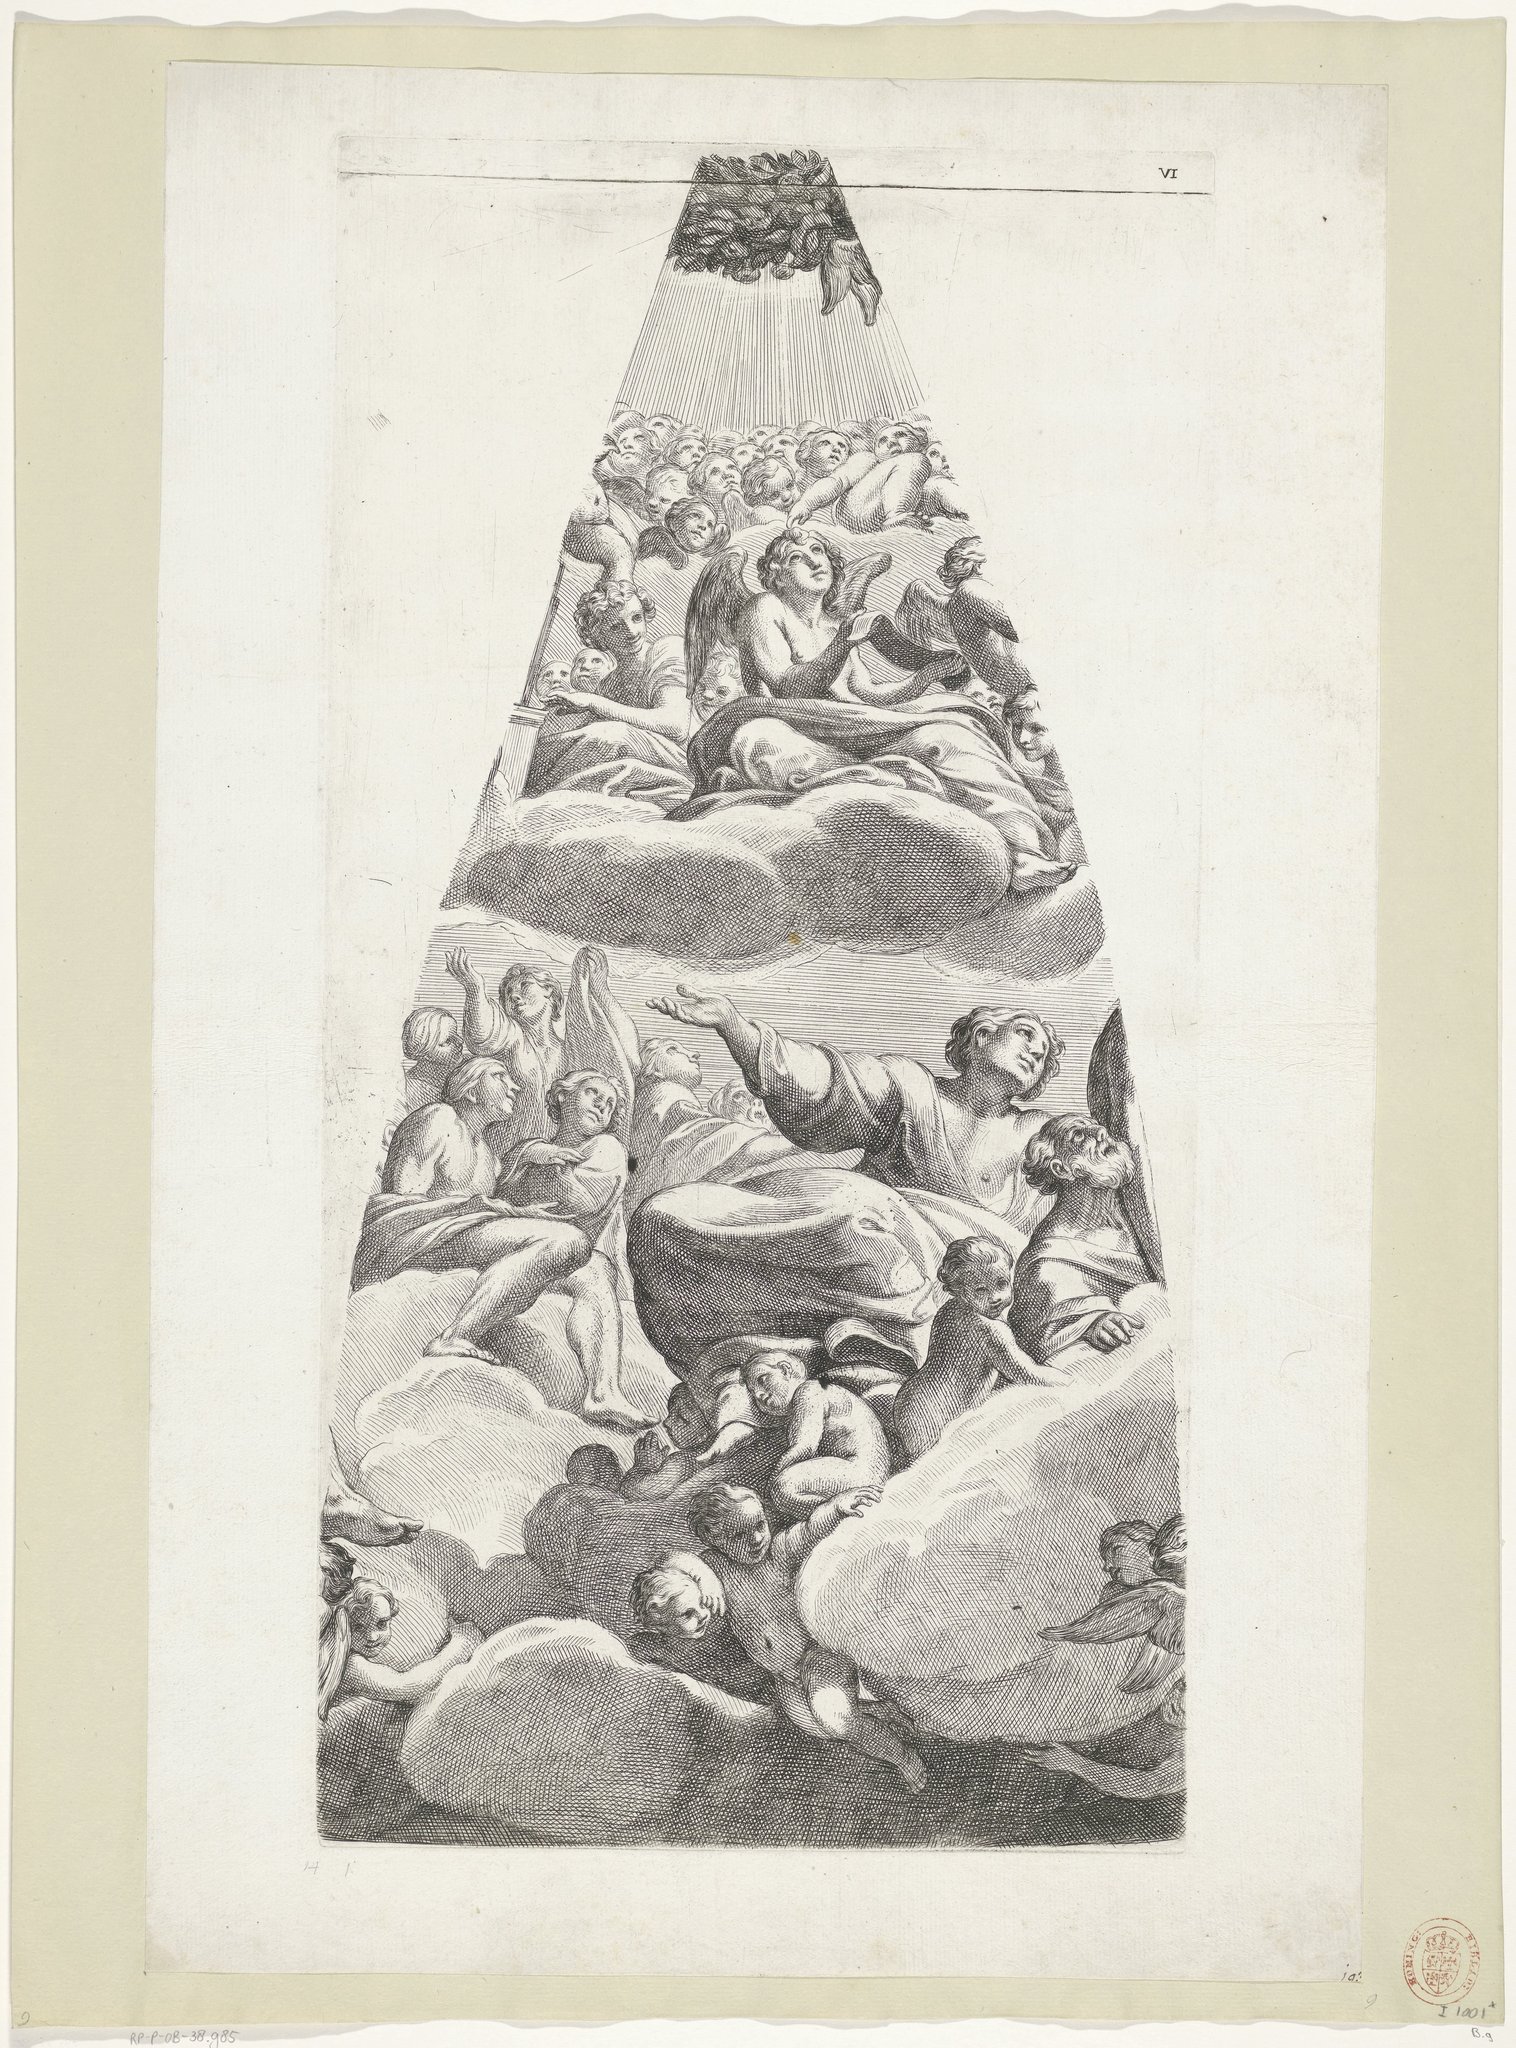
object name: print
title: Een jonge heilige gezeten op een wolk met engelen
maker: carlo cesio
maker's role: painter, print maker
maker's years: 1622-1682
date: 1636-1686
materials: paper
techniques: engraving, etching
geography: italy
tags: saints, angels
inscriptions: collector's mark: Lugt 240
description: Prent uit een reeks van 8 prenten naar de fresco's door Giovanni Lanfranco in de koepel van de San Andrea della Valle te Rome.